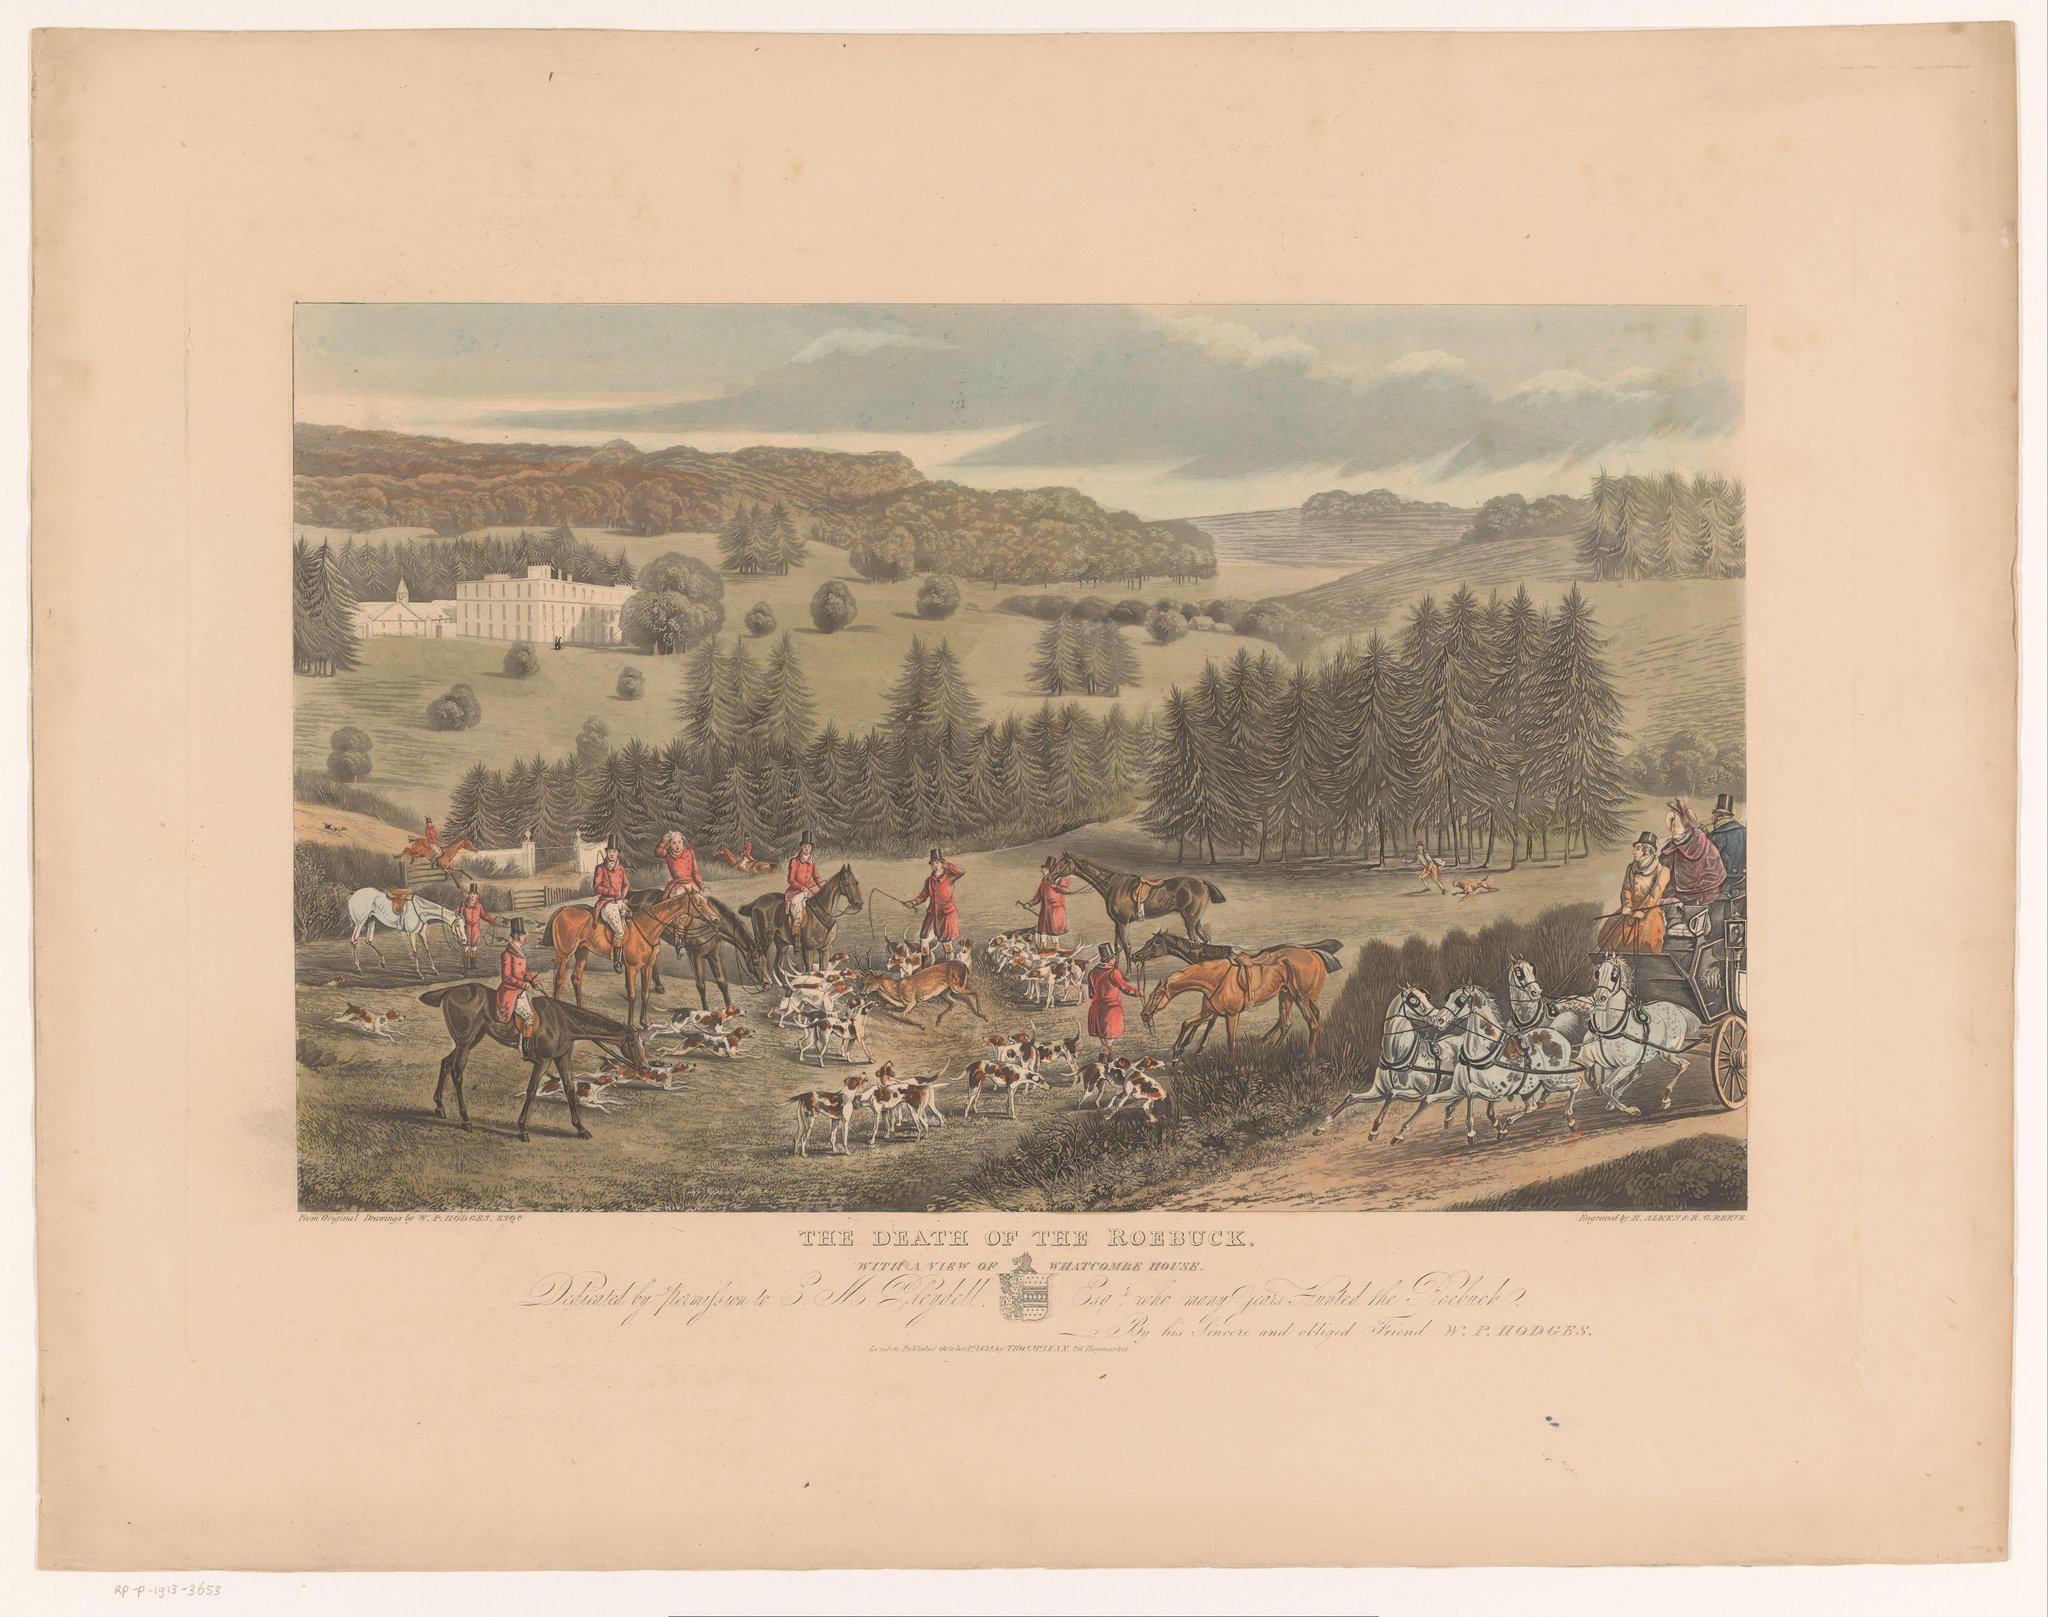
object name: print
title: The Death of the Roebuck, with a view of Whatcombe House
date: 1810-1831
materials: paper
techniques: aquatint, etching, hand coloring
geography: london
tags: riding a horse, ass, or mule; rider, horseman, stag-hunting, hunting dogs, game, hunted animals, four-wheeled vehicle drawn by more than three animals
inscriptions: collector's mark: Lugt 2233